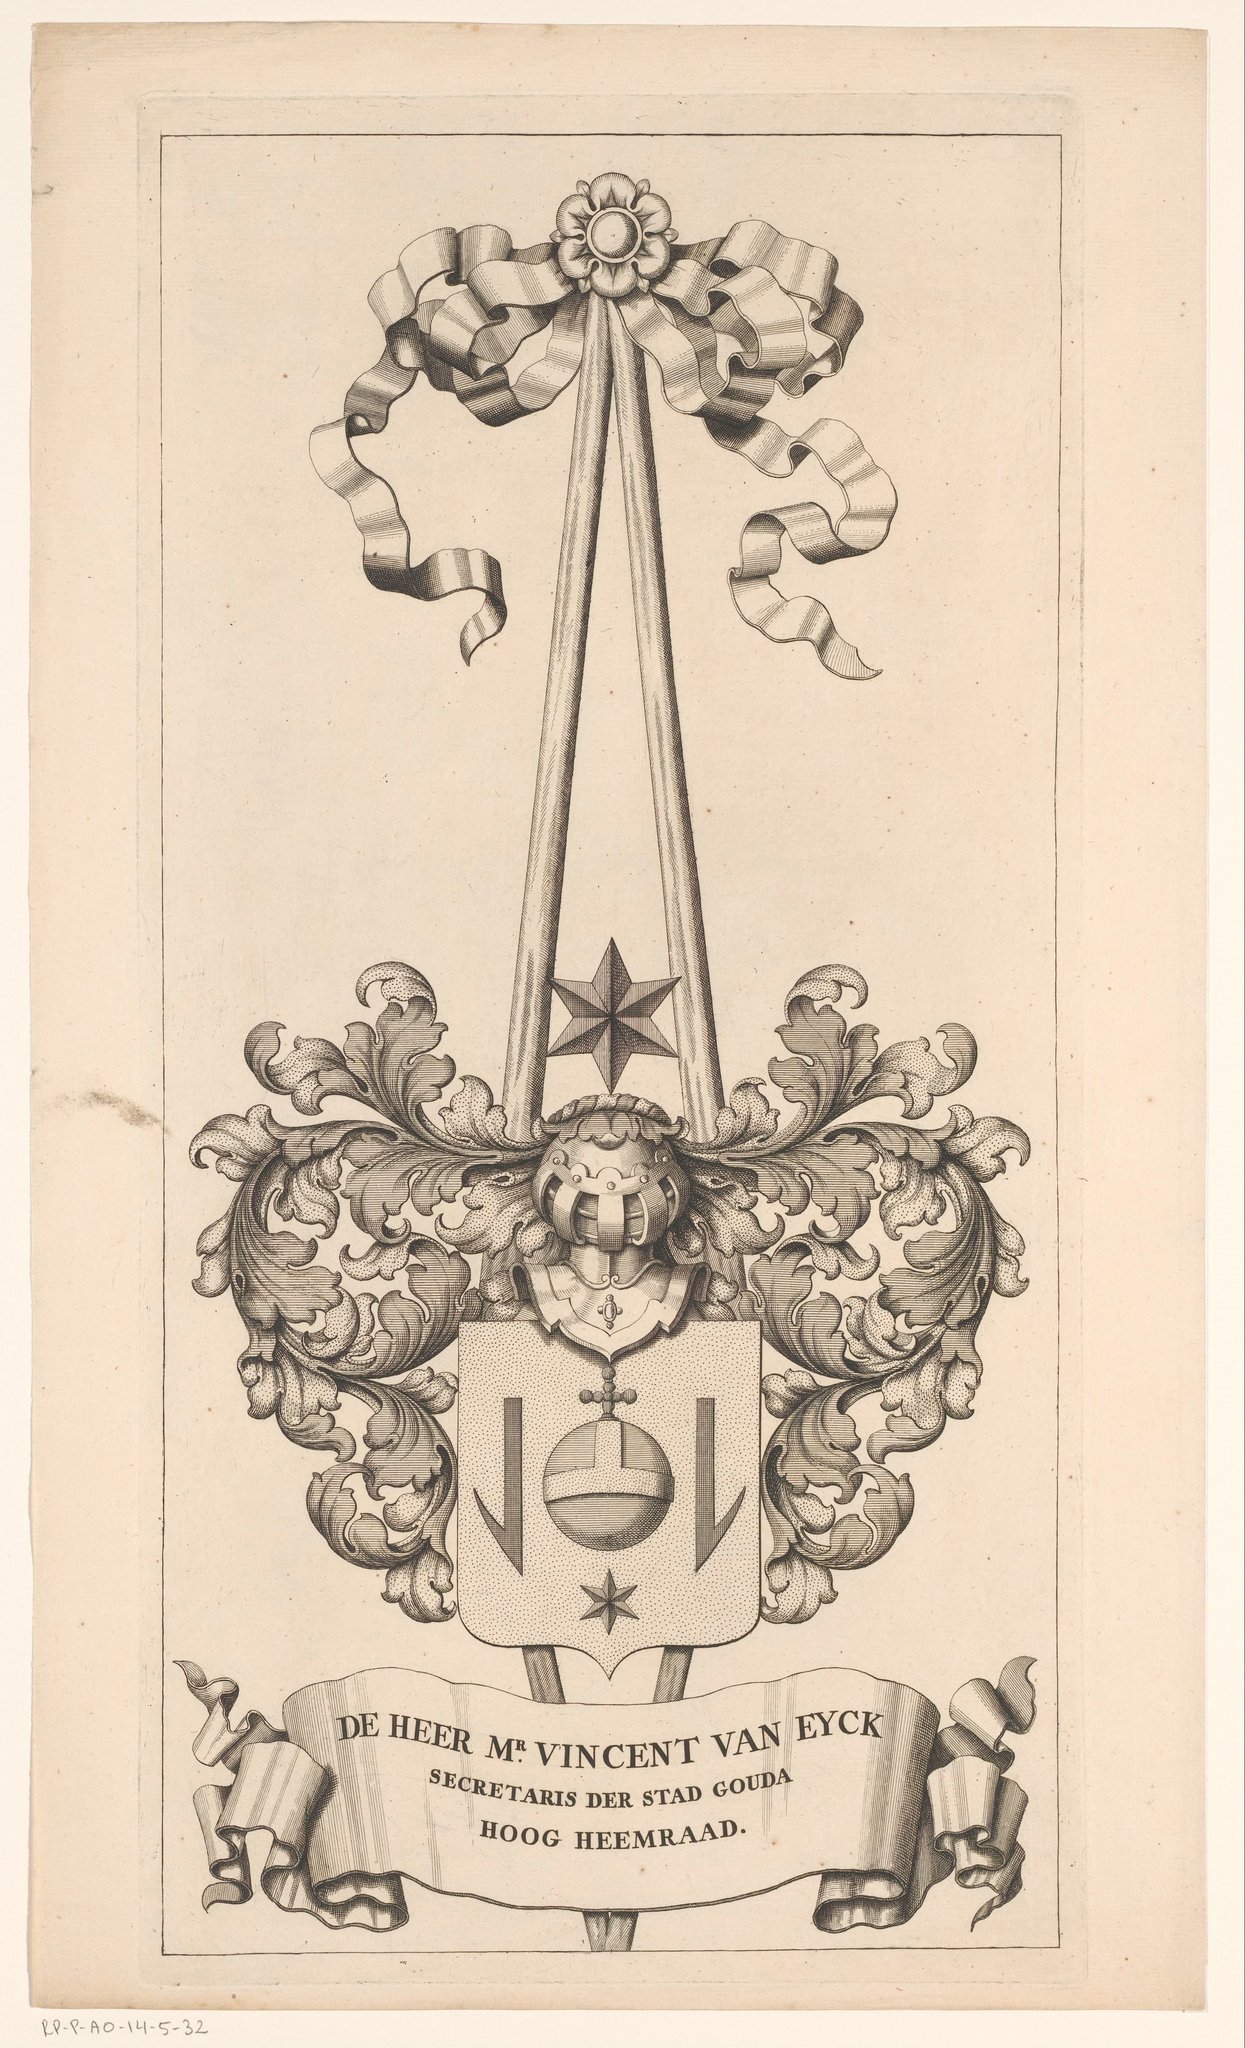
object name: print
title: Kaart van het Hoogheemraadschap van de Krimpenerwaard (deel wapenrand)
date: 1683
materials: paper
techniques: engraving, etching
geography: amsterdam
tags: armorial bearing, heraldry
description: Deel van de wapenrand van de vijfde druk van 'Het Hooge Heemraadschap van de Crimpenre Waard', een wandkaart (bestaande uit een kaart en een wapenrand) van het Hoogheemraadschap van de Krimpenerwaard.